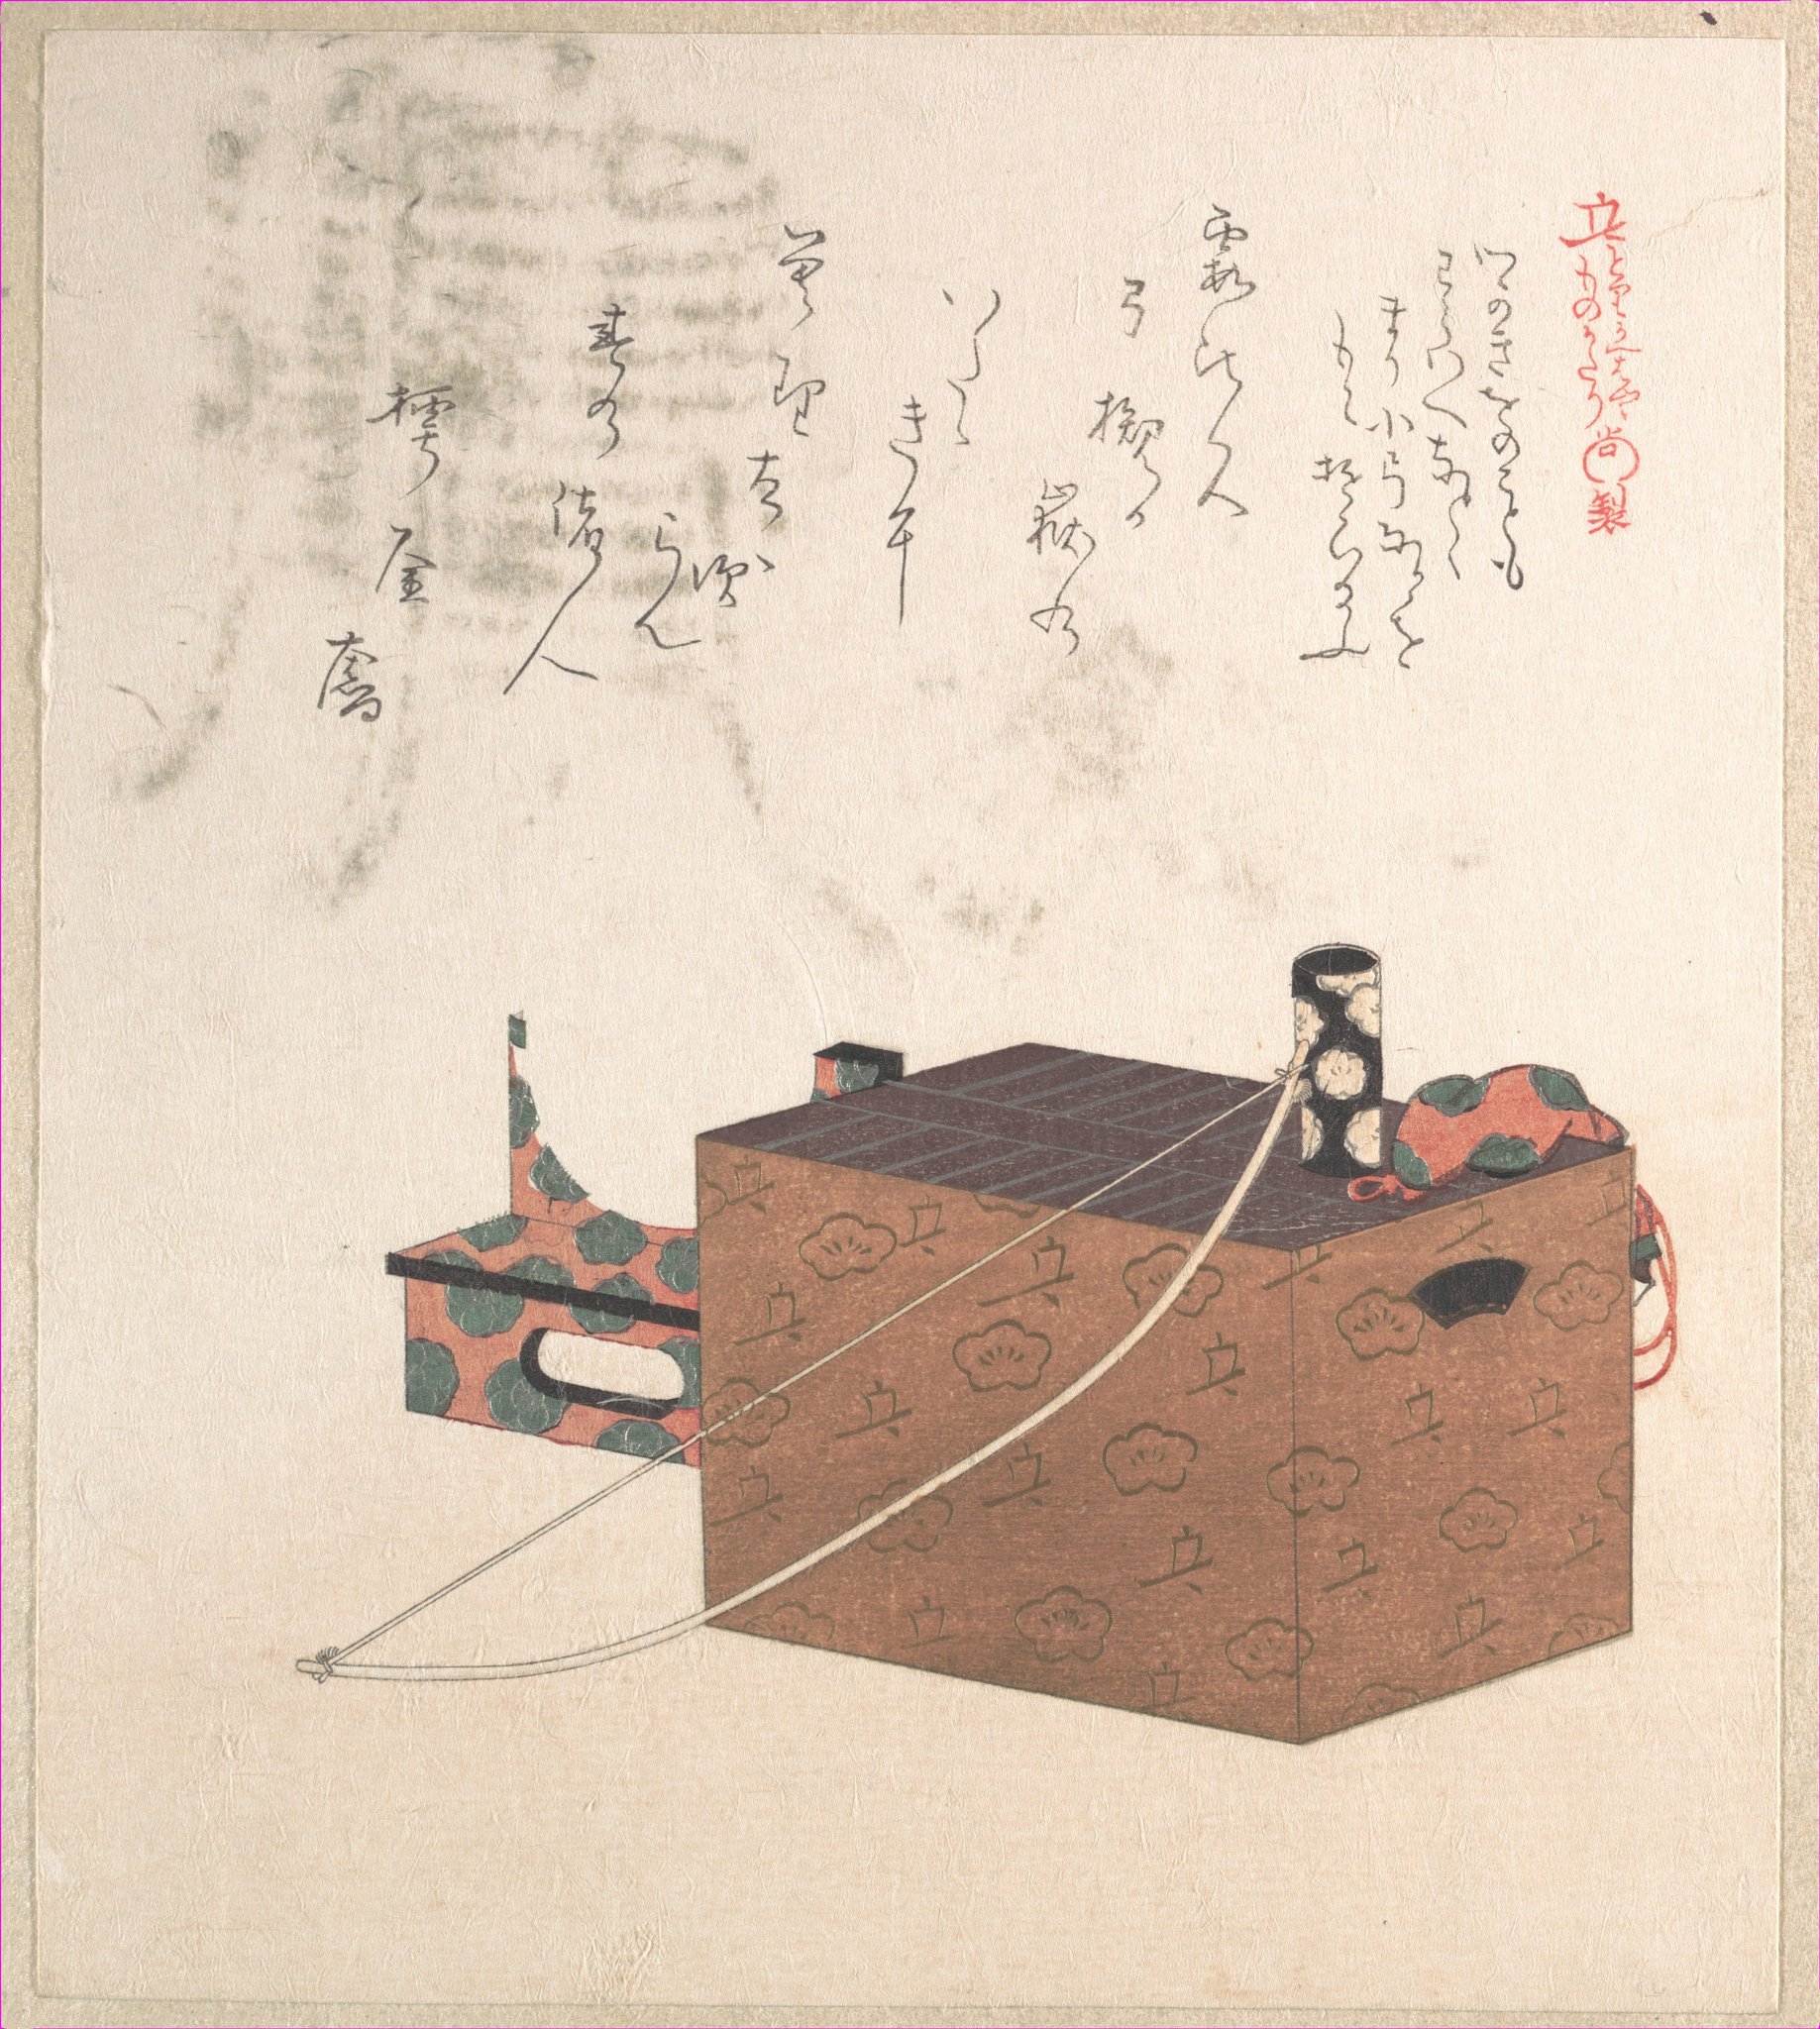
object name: woodblock print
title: Box for Sugoroku Game (A Kind of Backgammon), Bow and Drum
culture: japanese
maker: kubo shunman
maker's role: artist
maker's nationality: japanese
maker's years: 1757-1820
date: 1801-1900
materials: ink, paper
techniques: surimono, woodblock print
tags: games